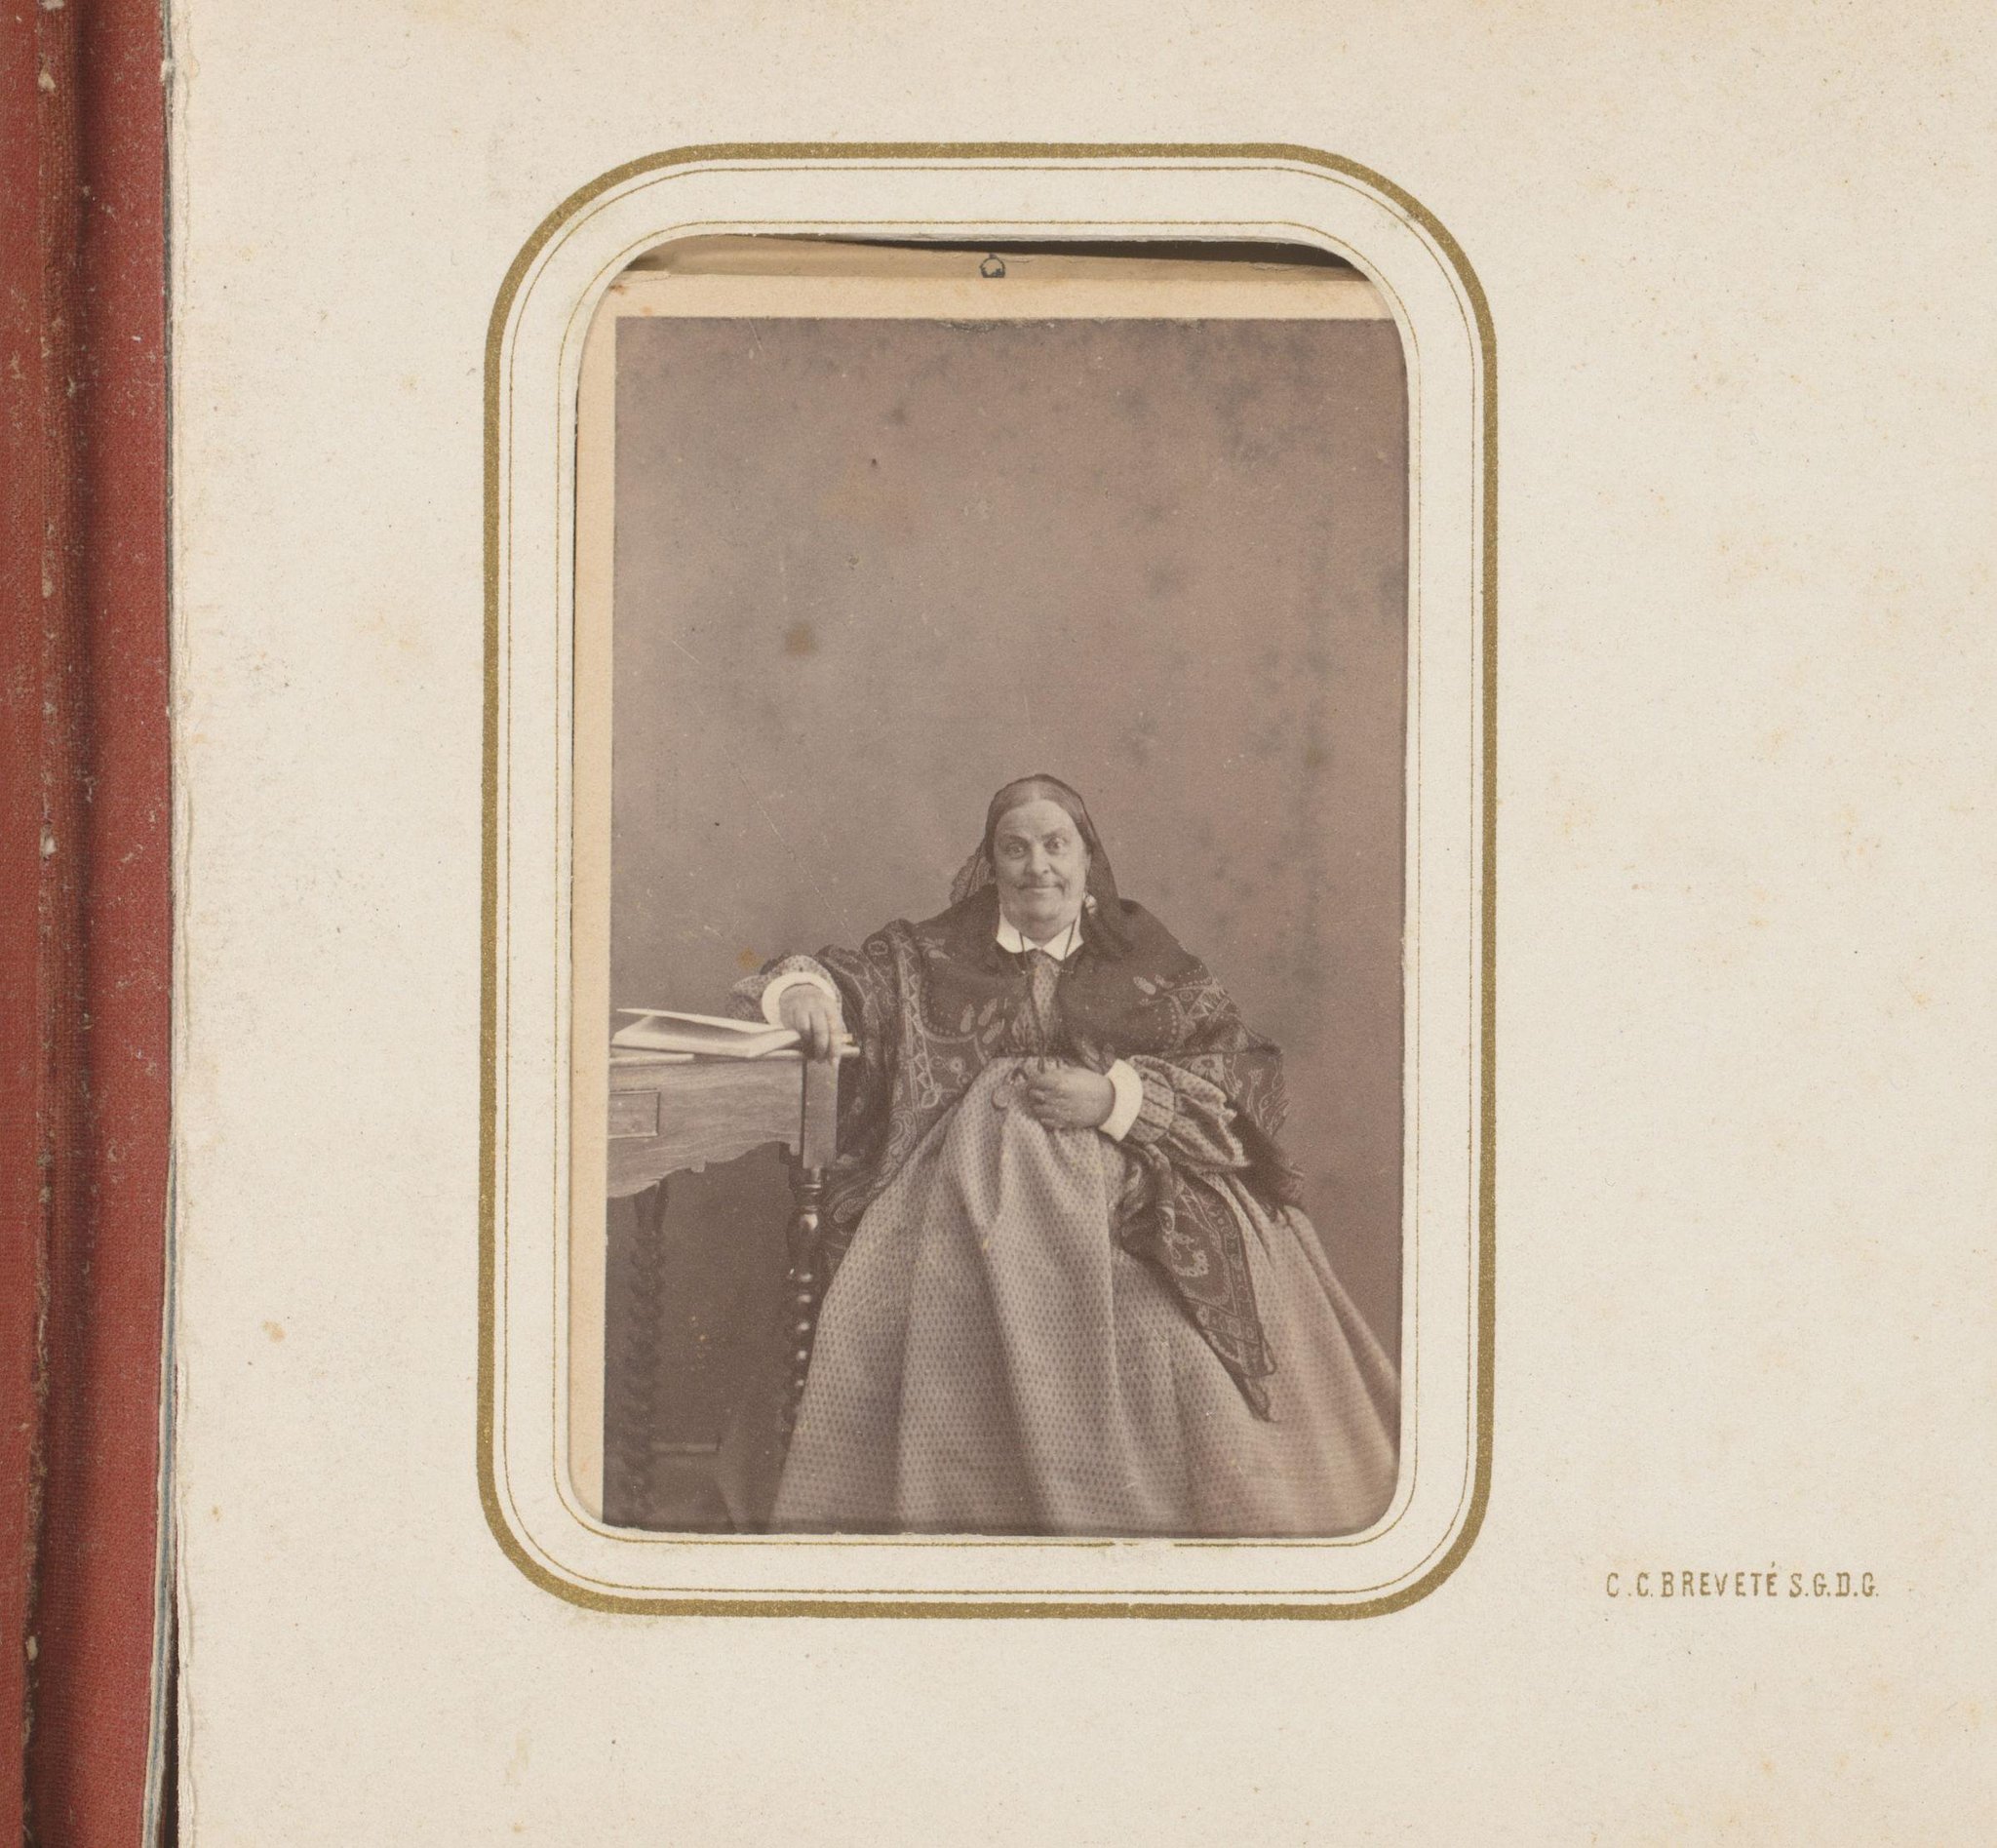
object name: photograph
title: Portret van een vrouw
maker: agostin ibarrola goicoechea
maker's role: fotograaf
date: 1860-1900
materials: cardboard, photographic support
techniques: albumen print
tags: sitting figure, adult woman, historical persons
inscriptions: inscription: ‘A. Goicoechea/ Fotógrafo de Madrid/ discipulo de Martinez Hebert’